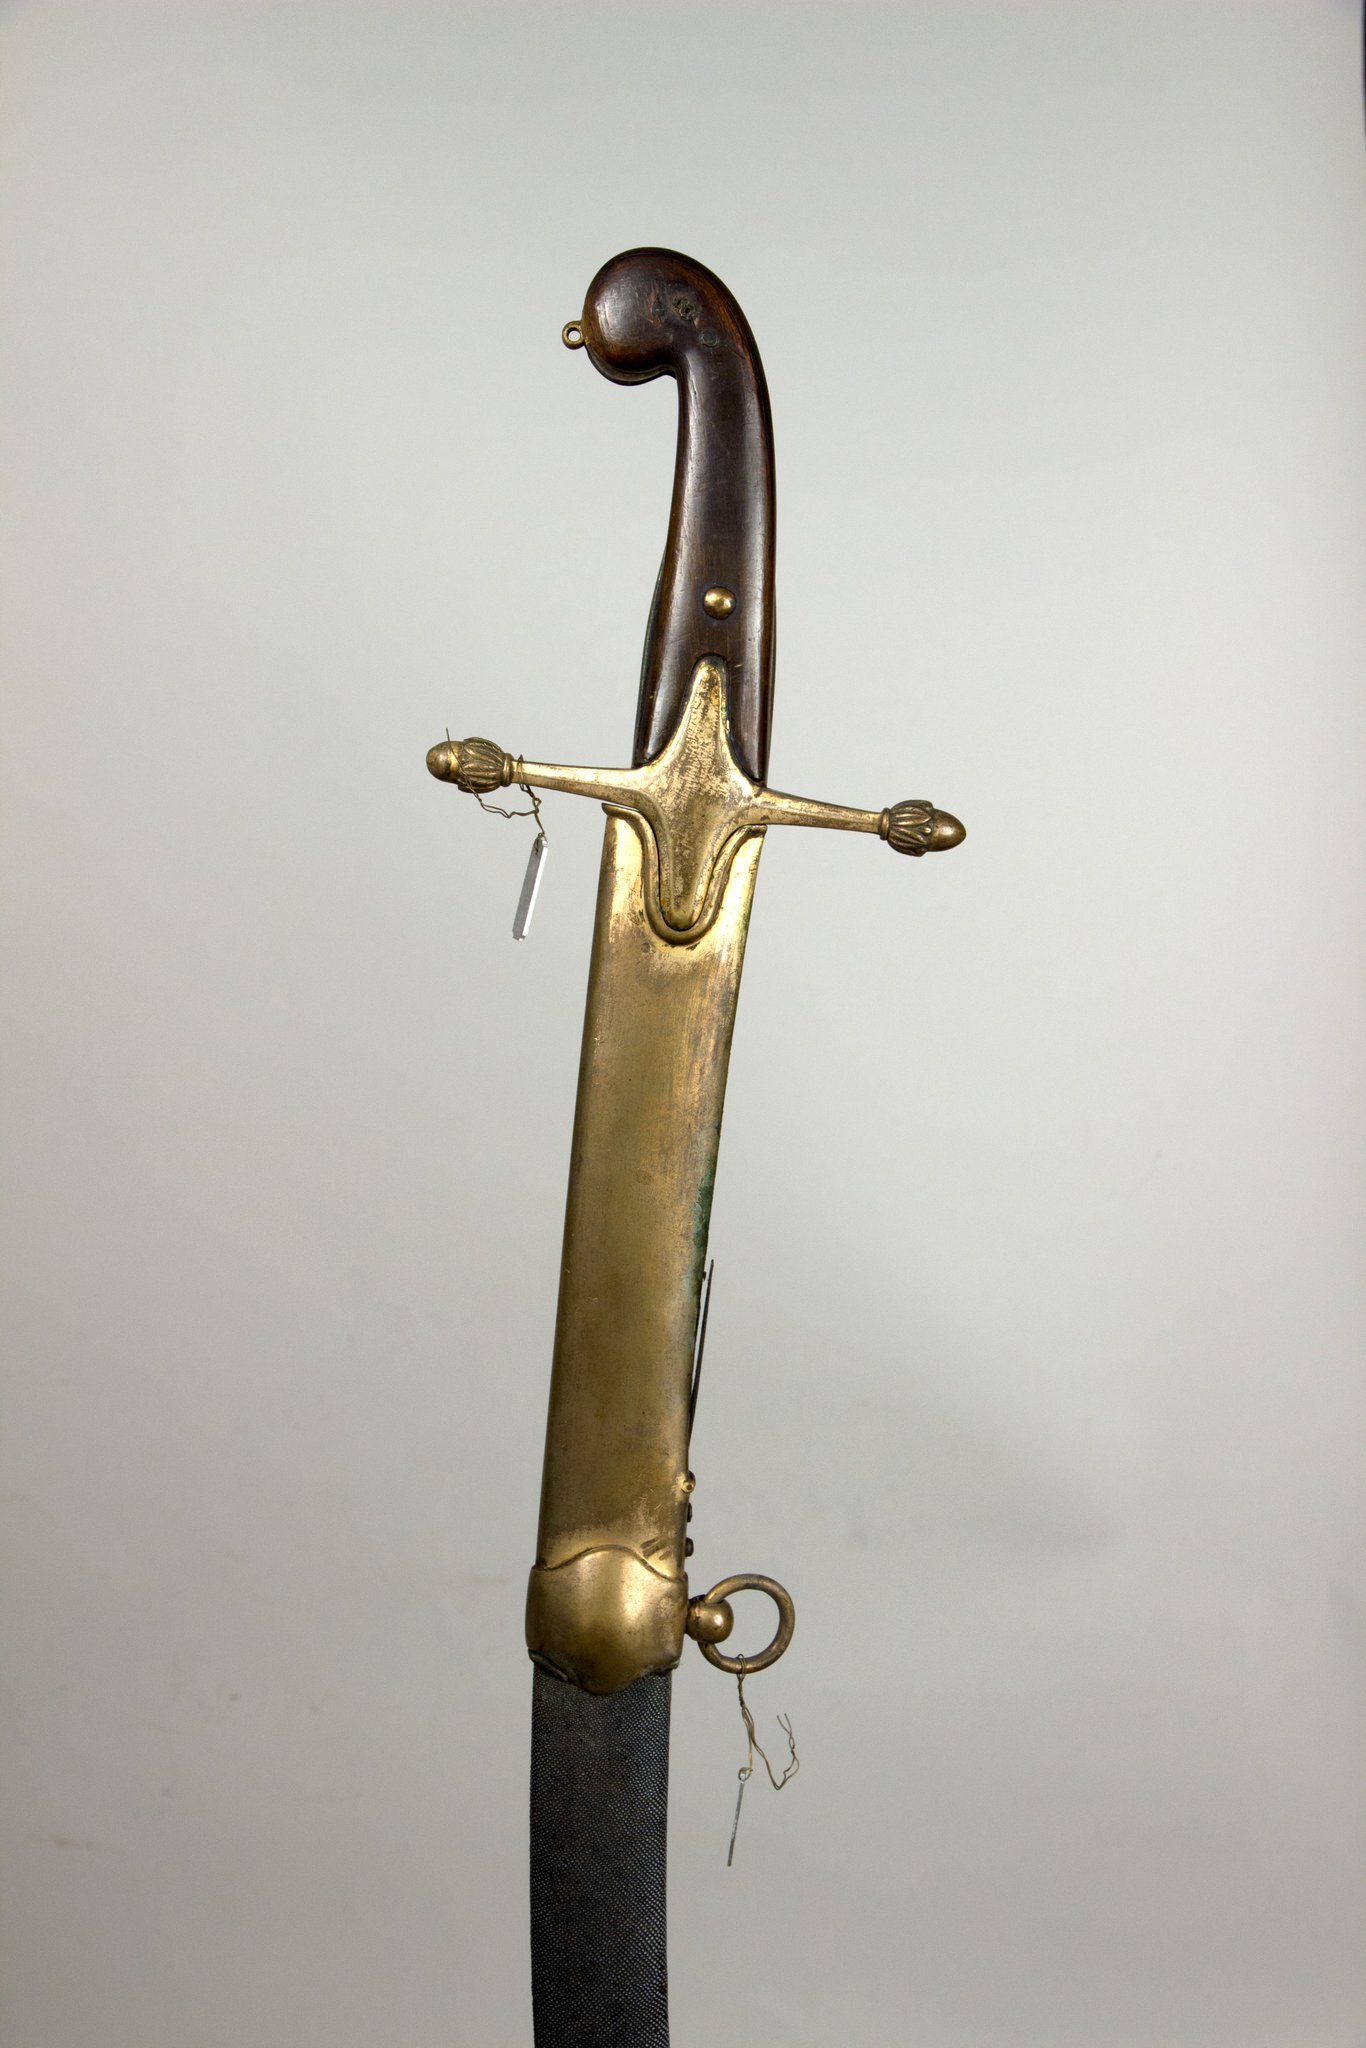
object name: sword kilij with scabbard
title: Sword (Kilij) with Scabbard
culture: turkish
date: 1801-1900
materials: brass, horn, leather, steel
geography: ottoman empire